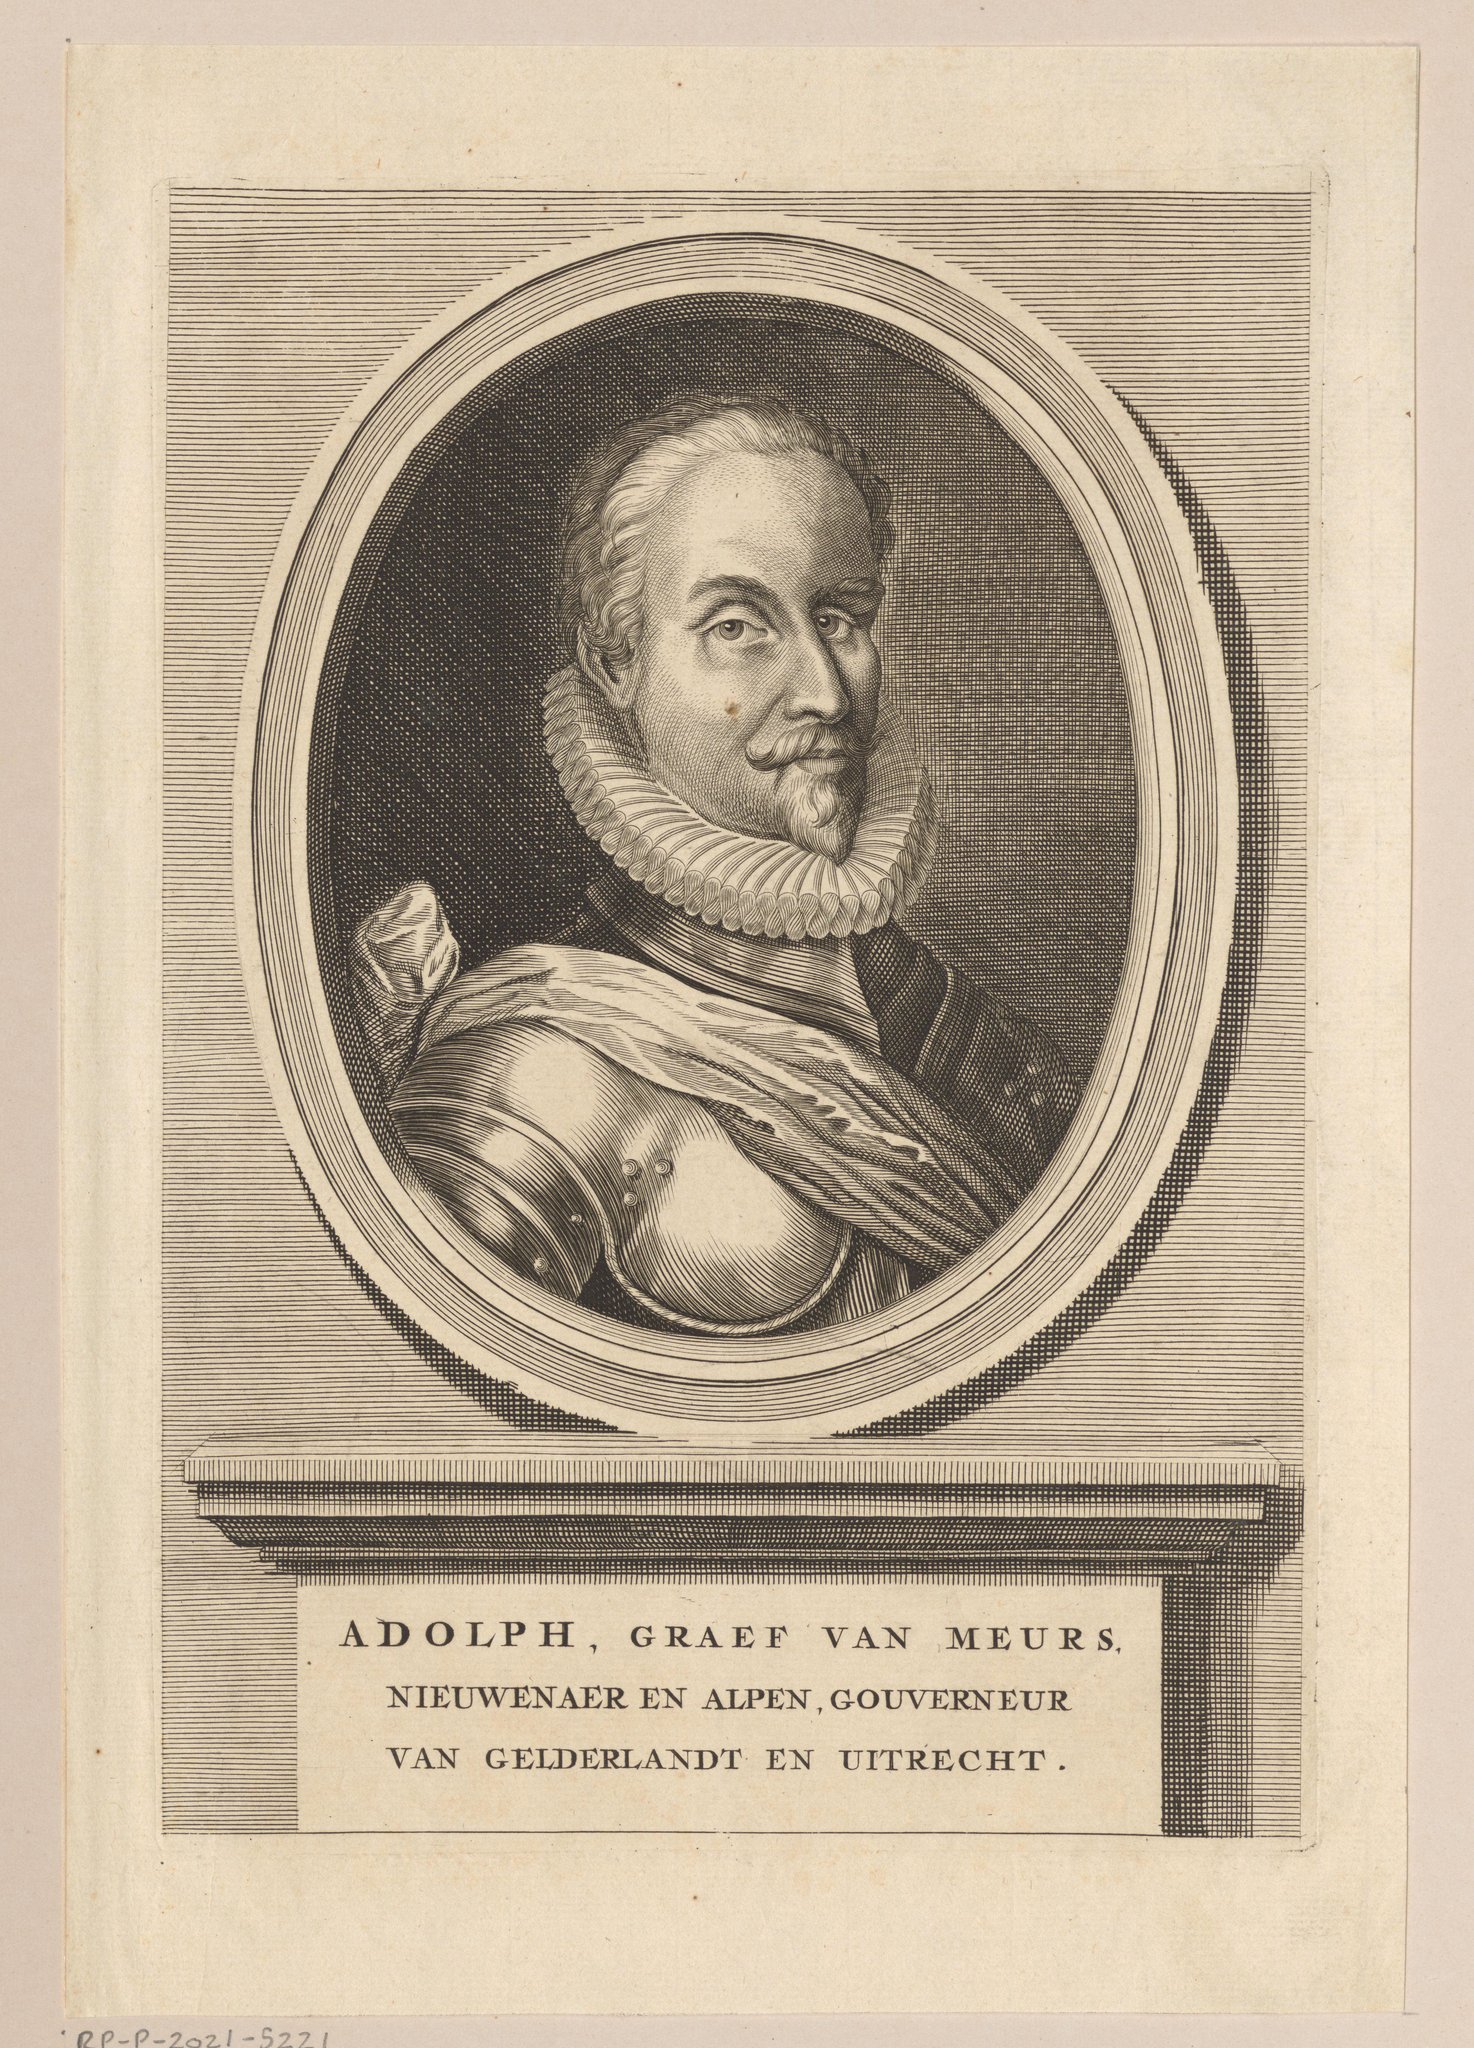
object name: print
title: Portret van Adolf, graaf van Nieuwenaar en Meurs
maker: Anonymous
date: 1679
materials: paper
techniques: engraving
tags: commander-in-chief, general, marshal, historical persons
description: Prent mogelijk uit: Bor, Pieter Christiaensz. Oorsprongk, begin en vervolgh der Nederlandsche oorlogen (...). Amsterdam: weduwe Joannes van Someren et al., 1679. Latere staat van prent gebruikt in: Le Clerc, Jean. Geschiedenissen der Vereenigde Nederlanden (...). Amsterdam: Zacharias Chatelain, 1730.